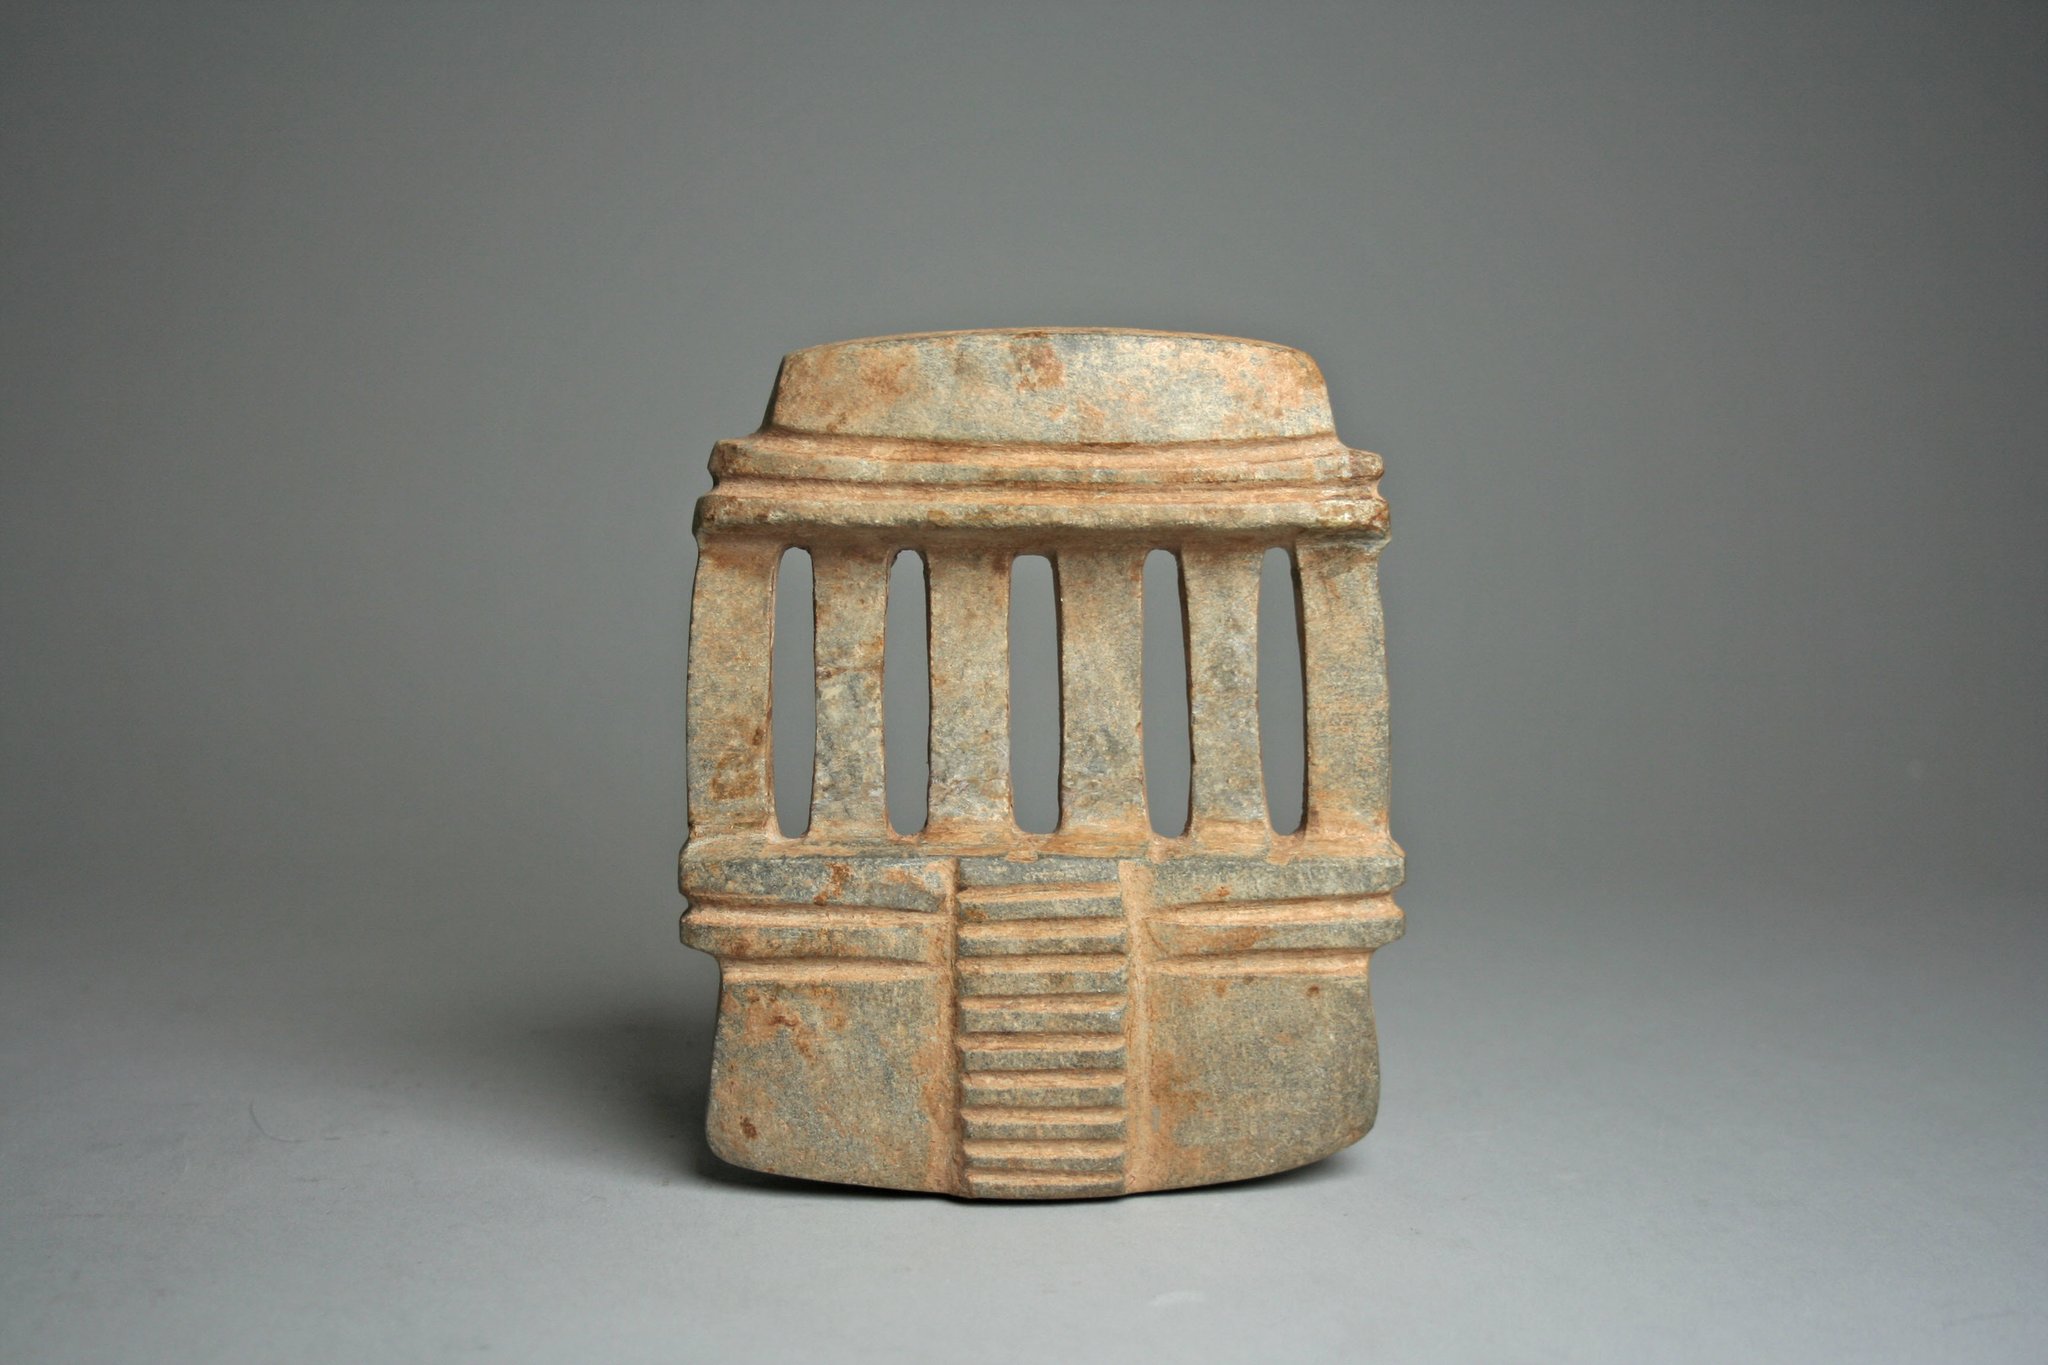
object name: architectural model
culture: mezcala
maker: mezcala artist(s)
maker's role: artist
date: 300 BCE-300 CE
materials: stone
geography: mexico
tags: temples